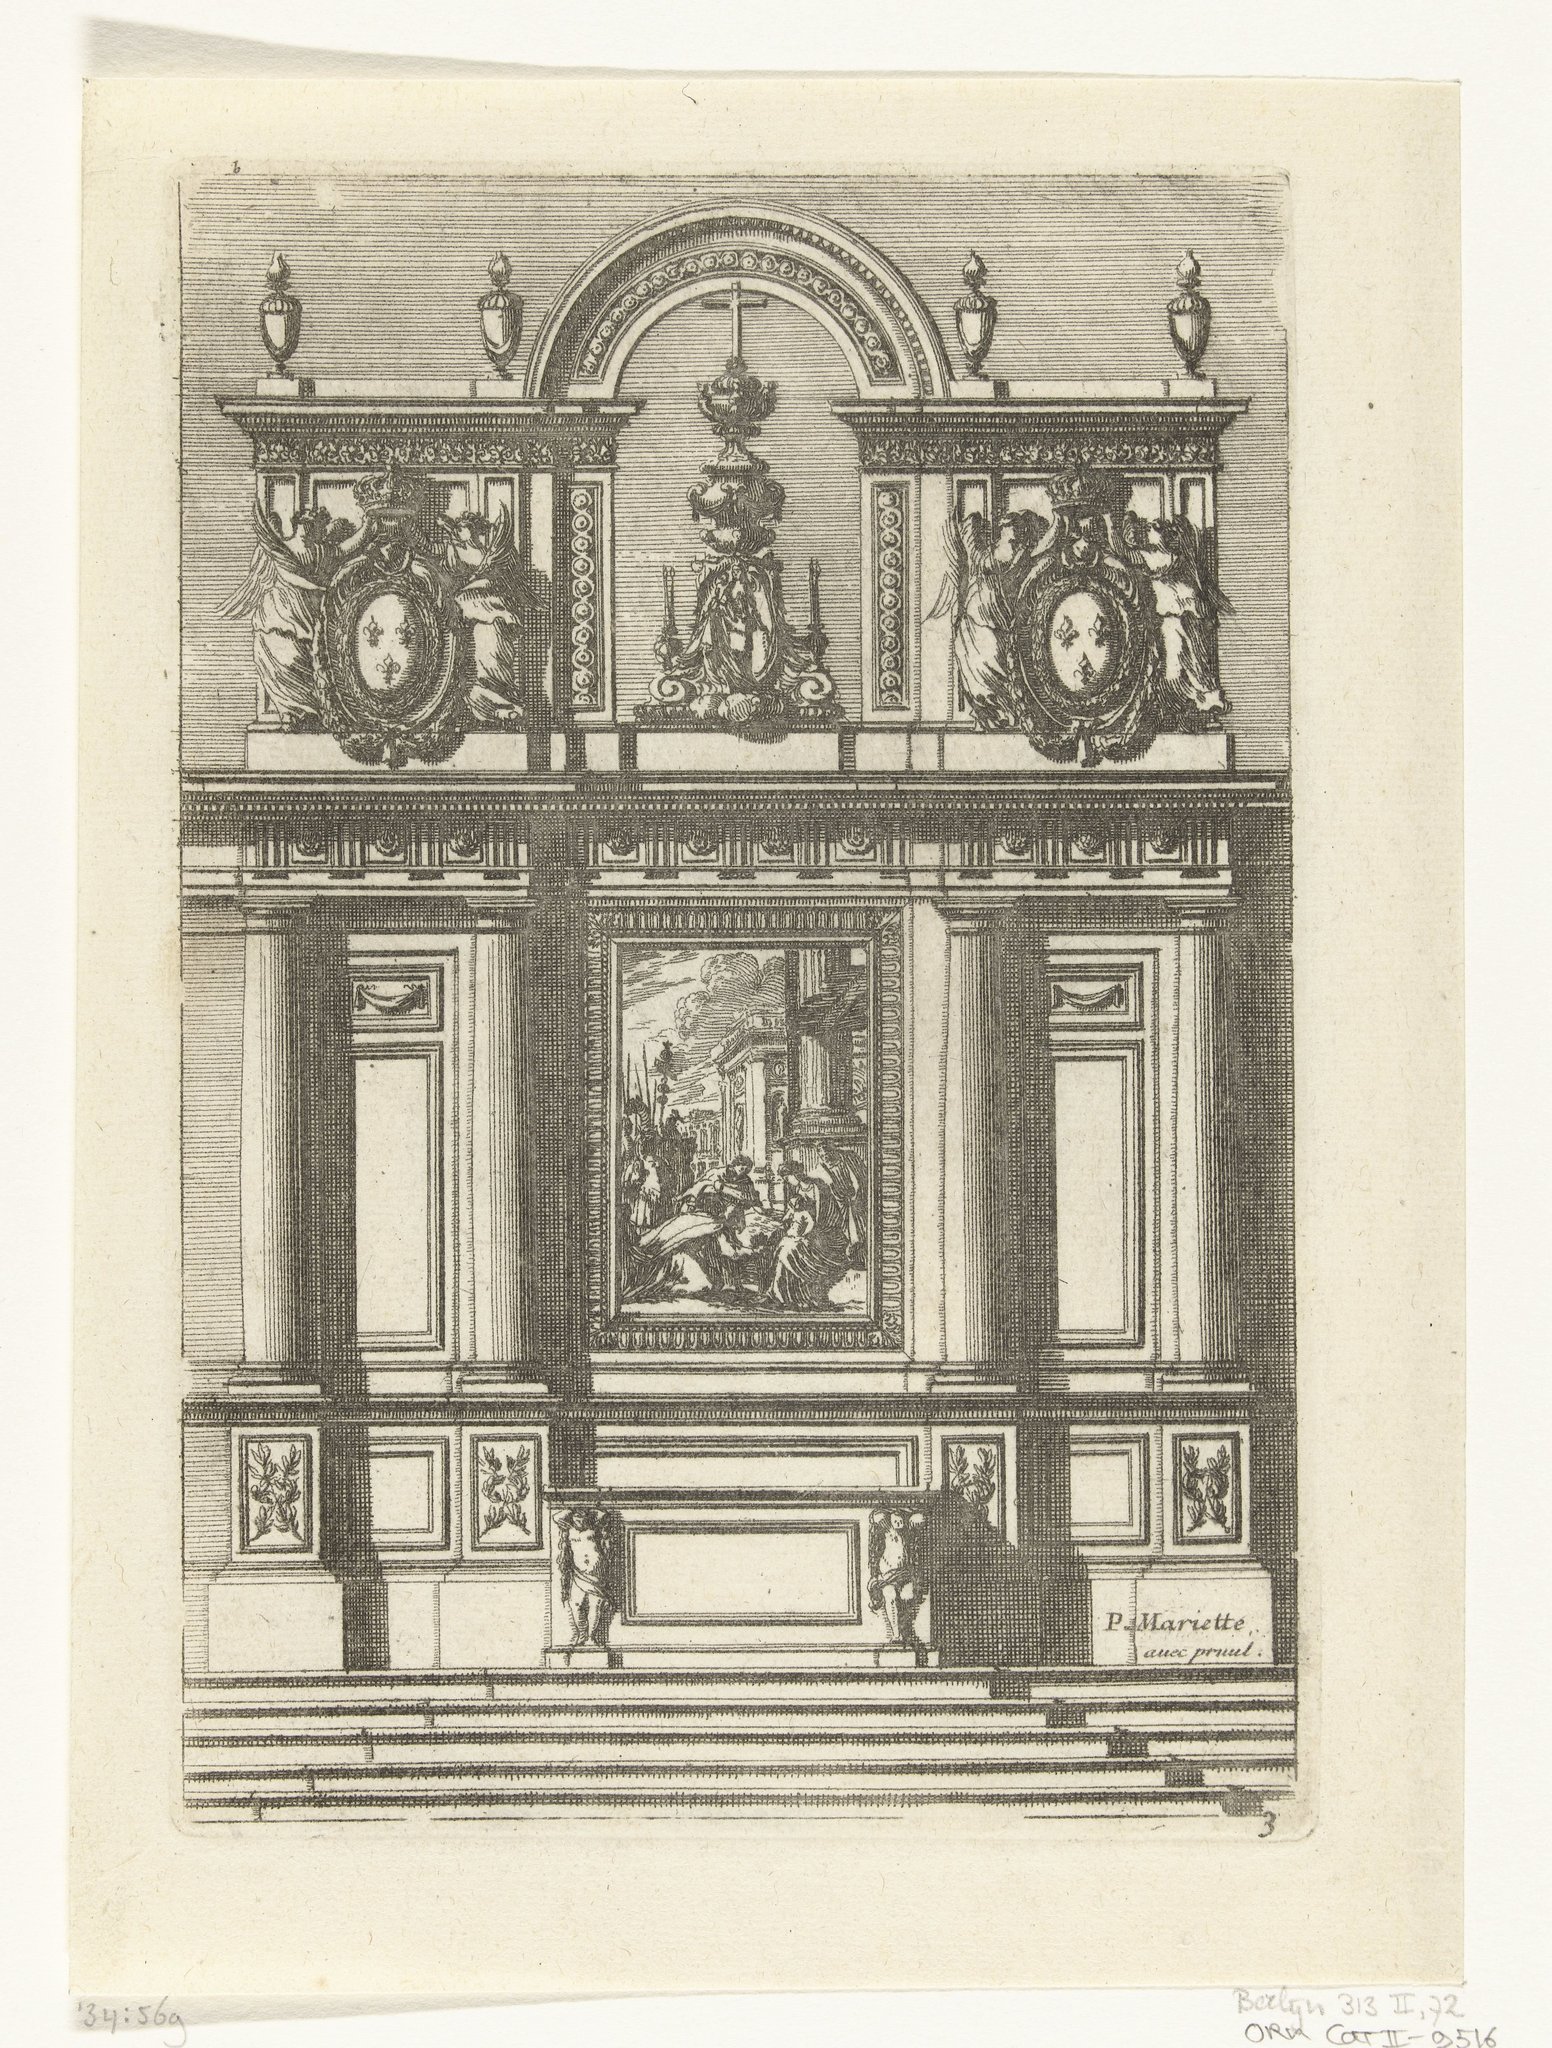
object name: print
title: Authels et Retables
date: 1666-1693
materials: paper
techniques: etching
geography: france